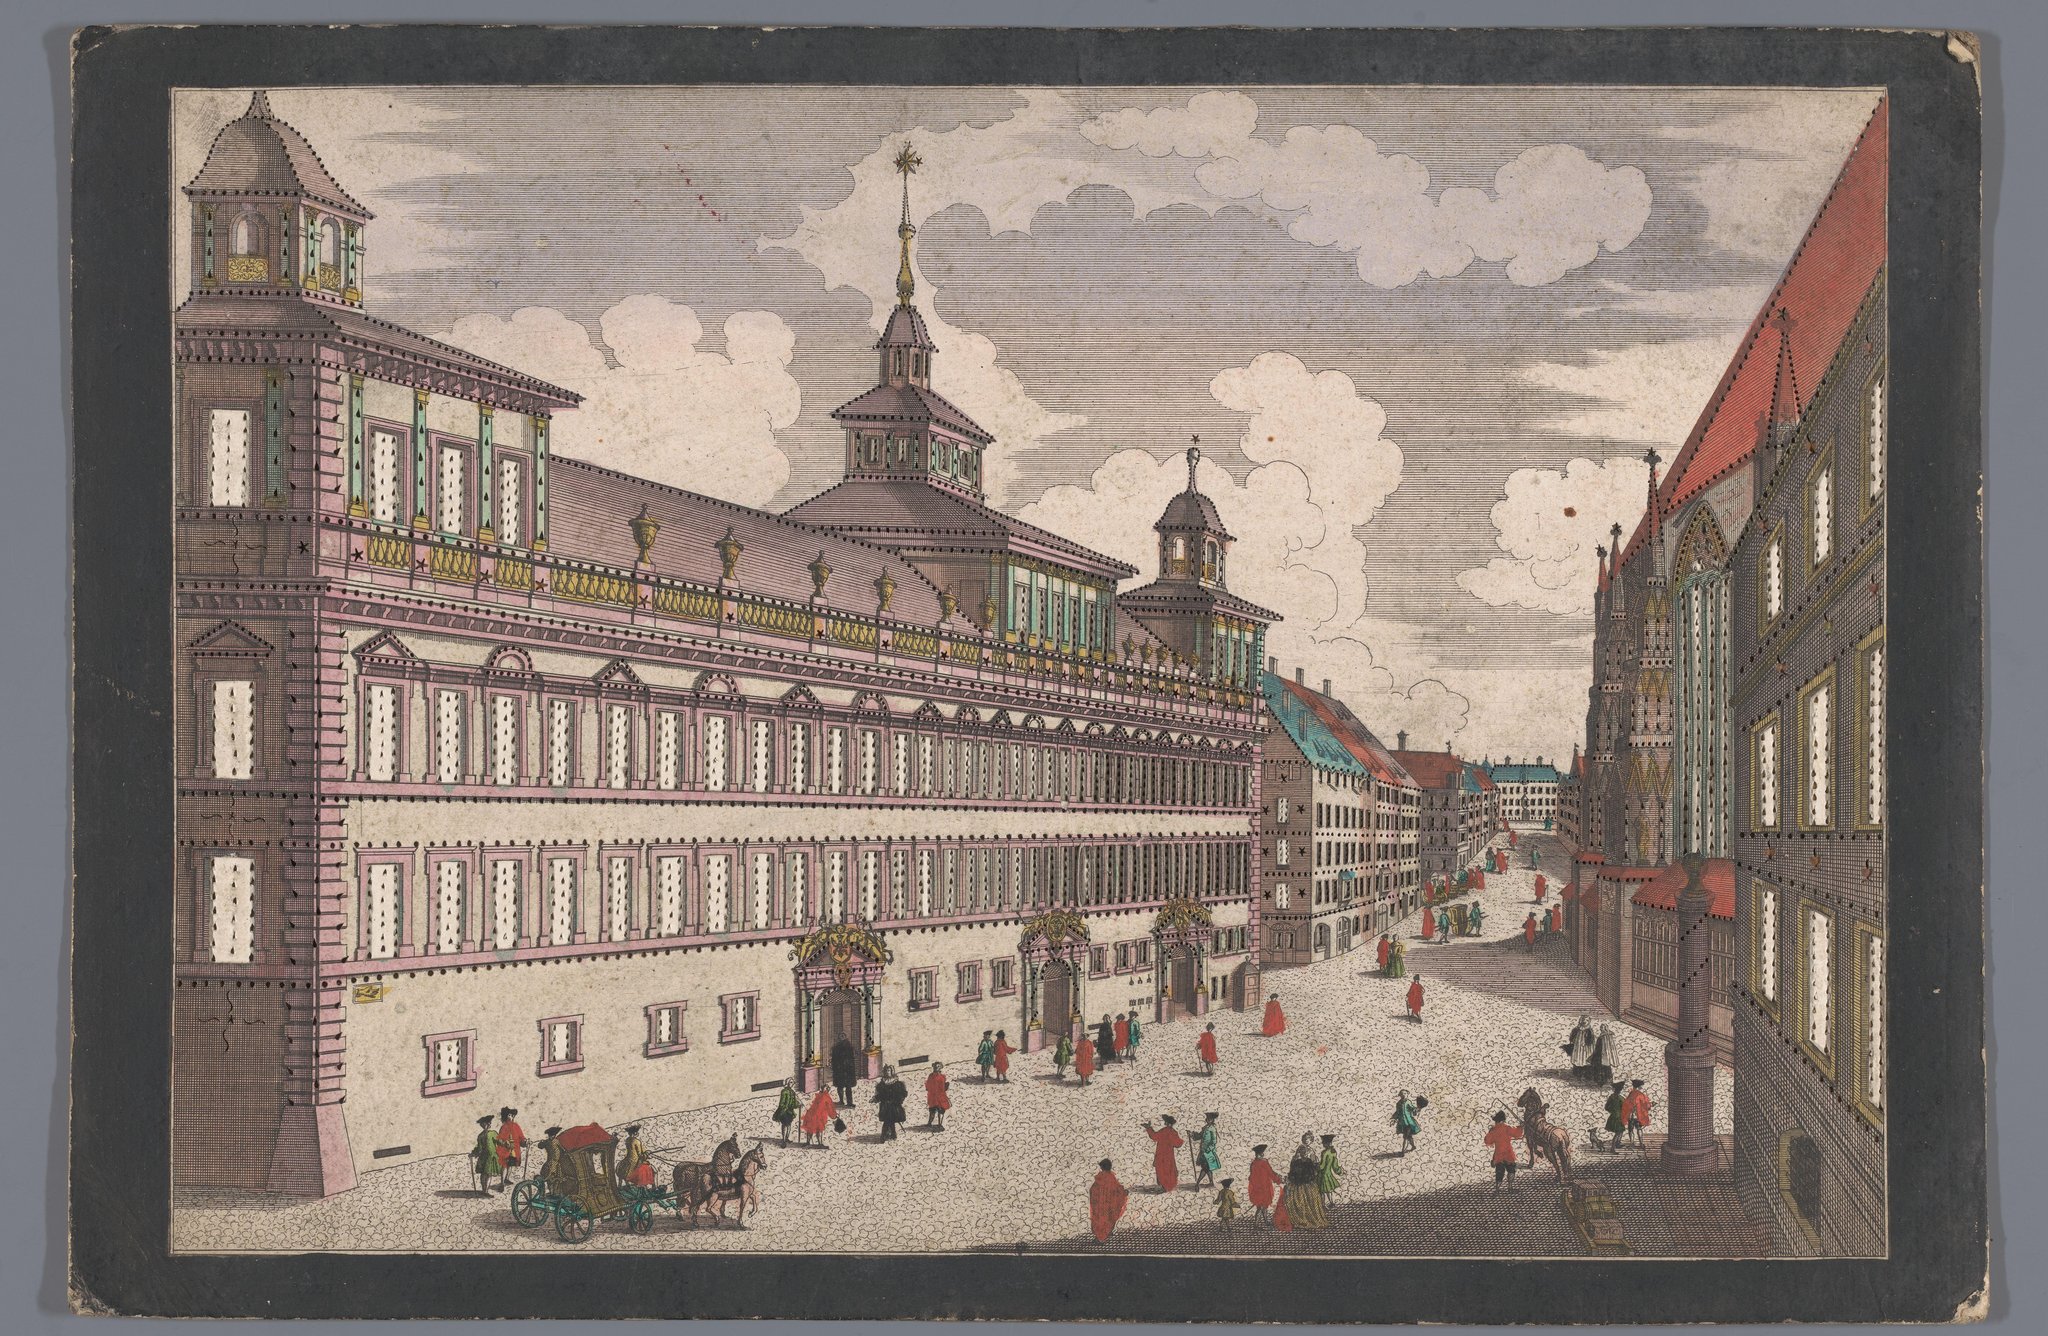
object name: print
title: Das Rathhauß zu Nürnberg gegen dem Marckt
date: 1742-1801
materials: cardboard, paint, paper, watercolor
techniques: brush, cutting, etching, perforating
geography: germany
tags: townhall, street (+ city(-scape) with figures, staffage)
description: Mogelijk rechtsboven genummerd geweest: 232. Mogelijk linksonder genummerd geweest: 57. De serie “Neurenberg”, met het nummer 57, bevat vier prenten met de nummers 232-235, waarvan dit mogelijk nummer 232 is.